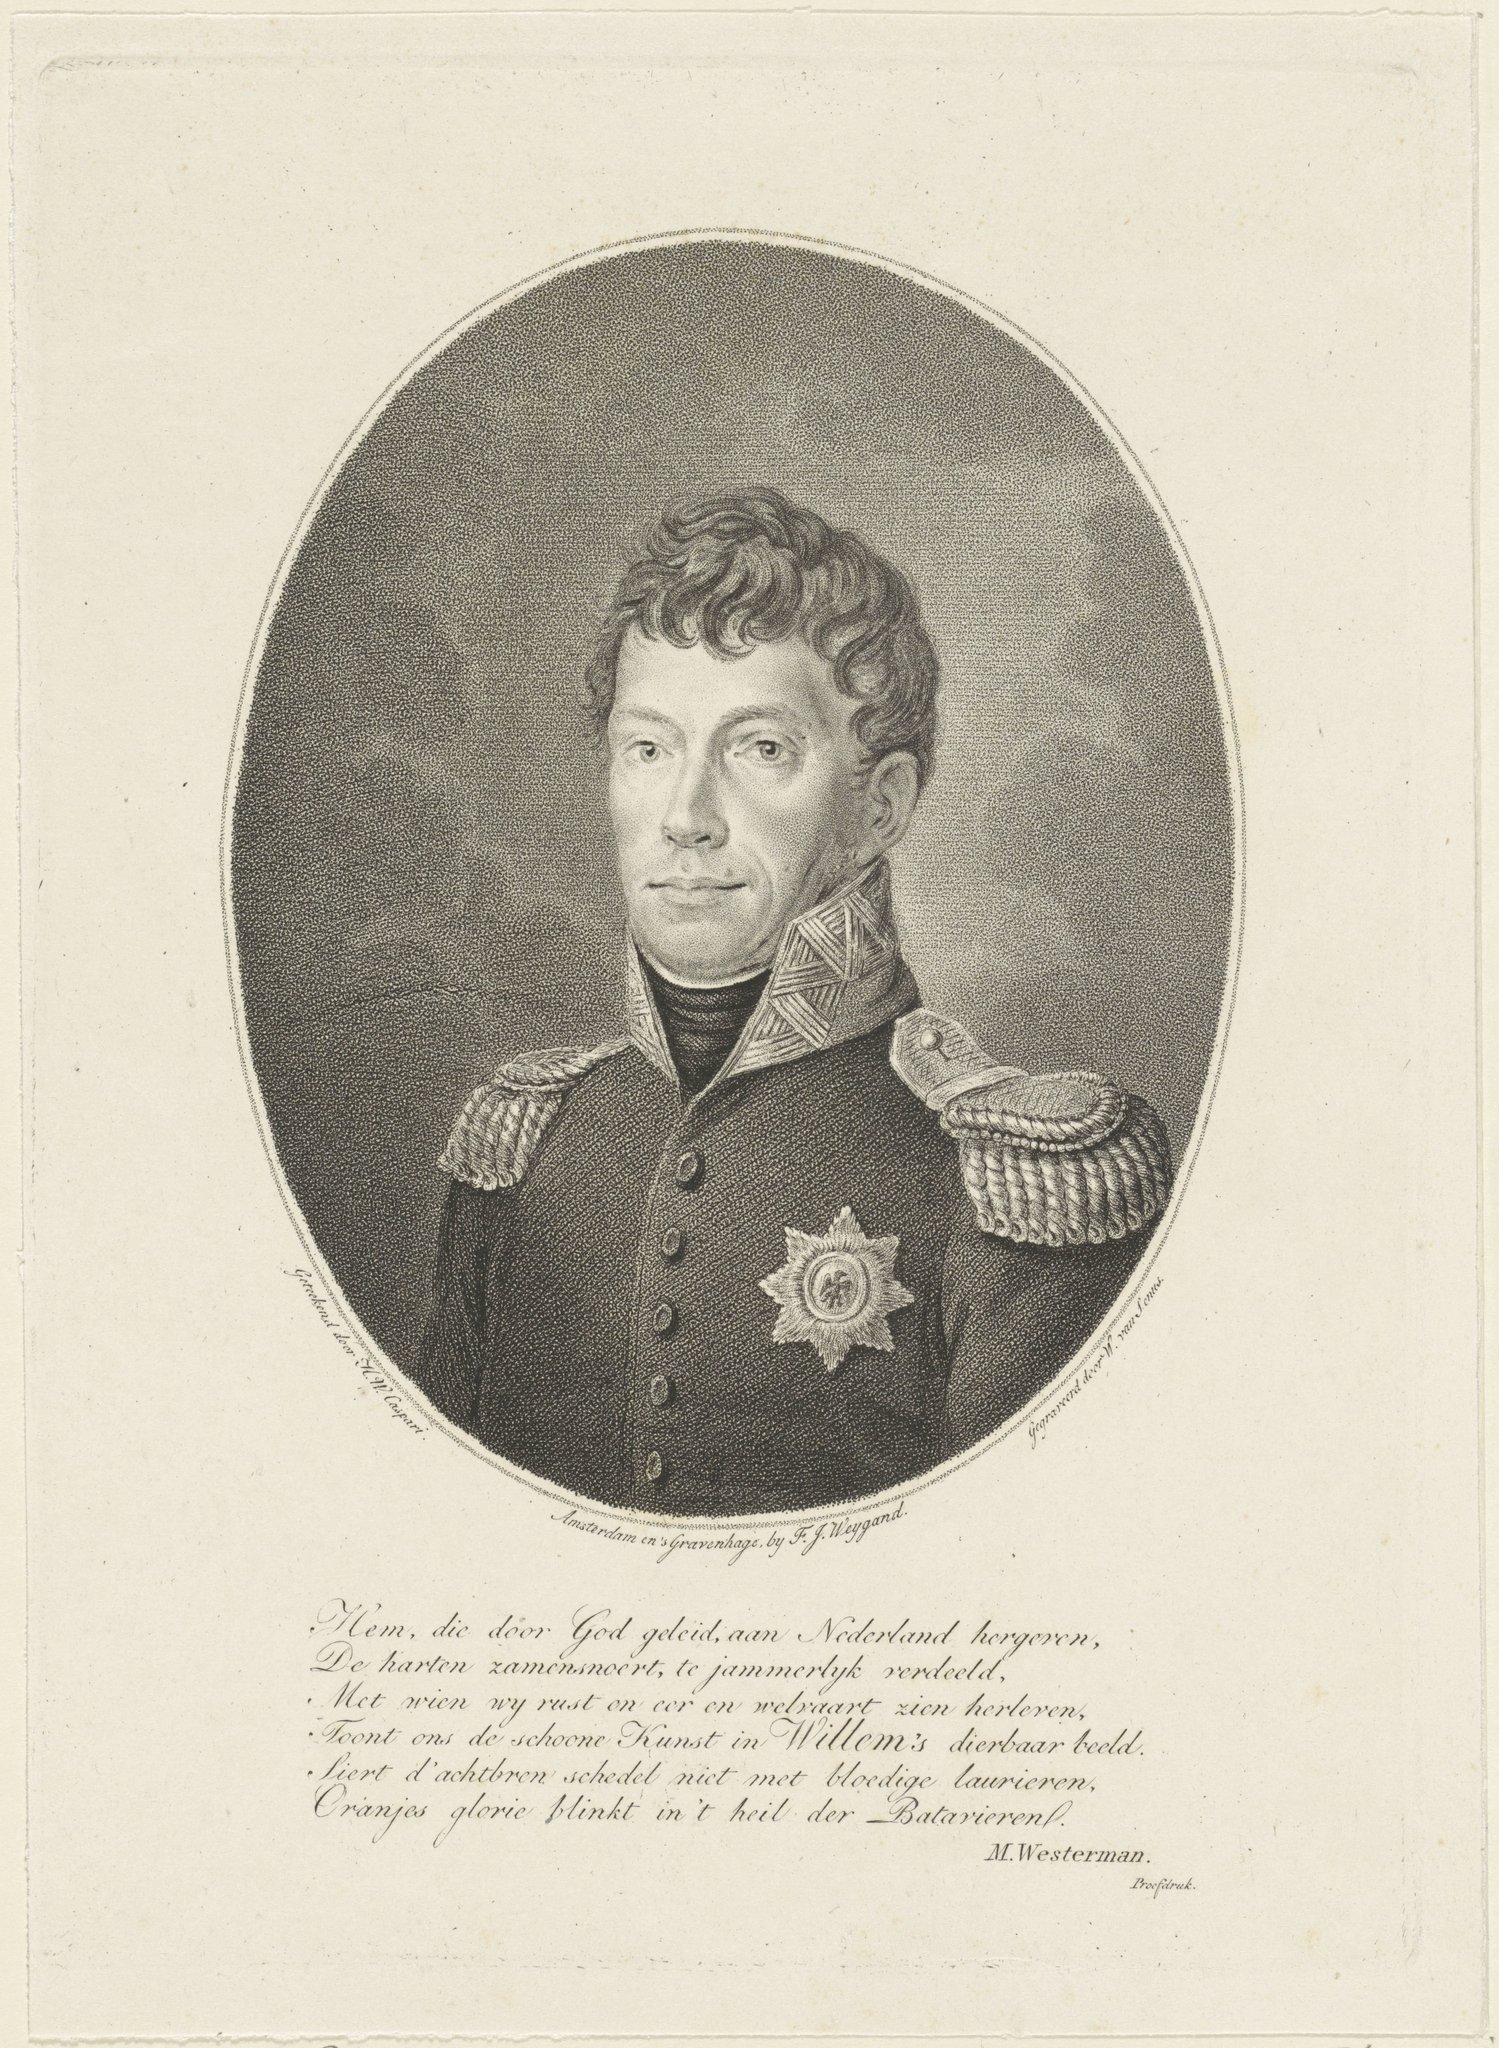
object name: print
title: Portret van Willem I Frederik, koning der Nederlanden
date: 1823-1839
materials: paper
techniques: engraving, etching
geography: the hague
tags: the hague, william i of the netherlands, knighthood order (with name) - insignia of a knighthood order, e.g.: badge, chain (with name of order)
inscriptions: collector's mark: Lugt 2166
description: De hier vermelde titel verwijst naar de hoogst verkregen titel van de geportretteerde, niet per se naar de titel die de geportretteerde op deze voorstelling draagt.